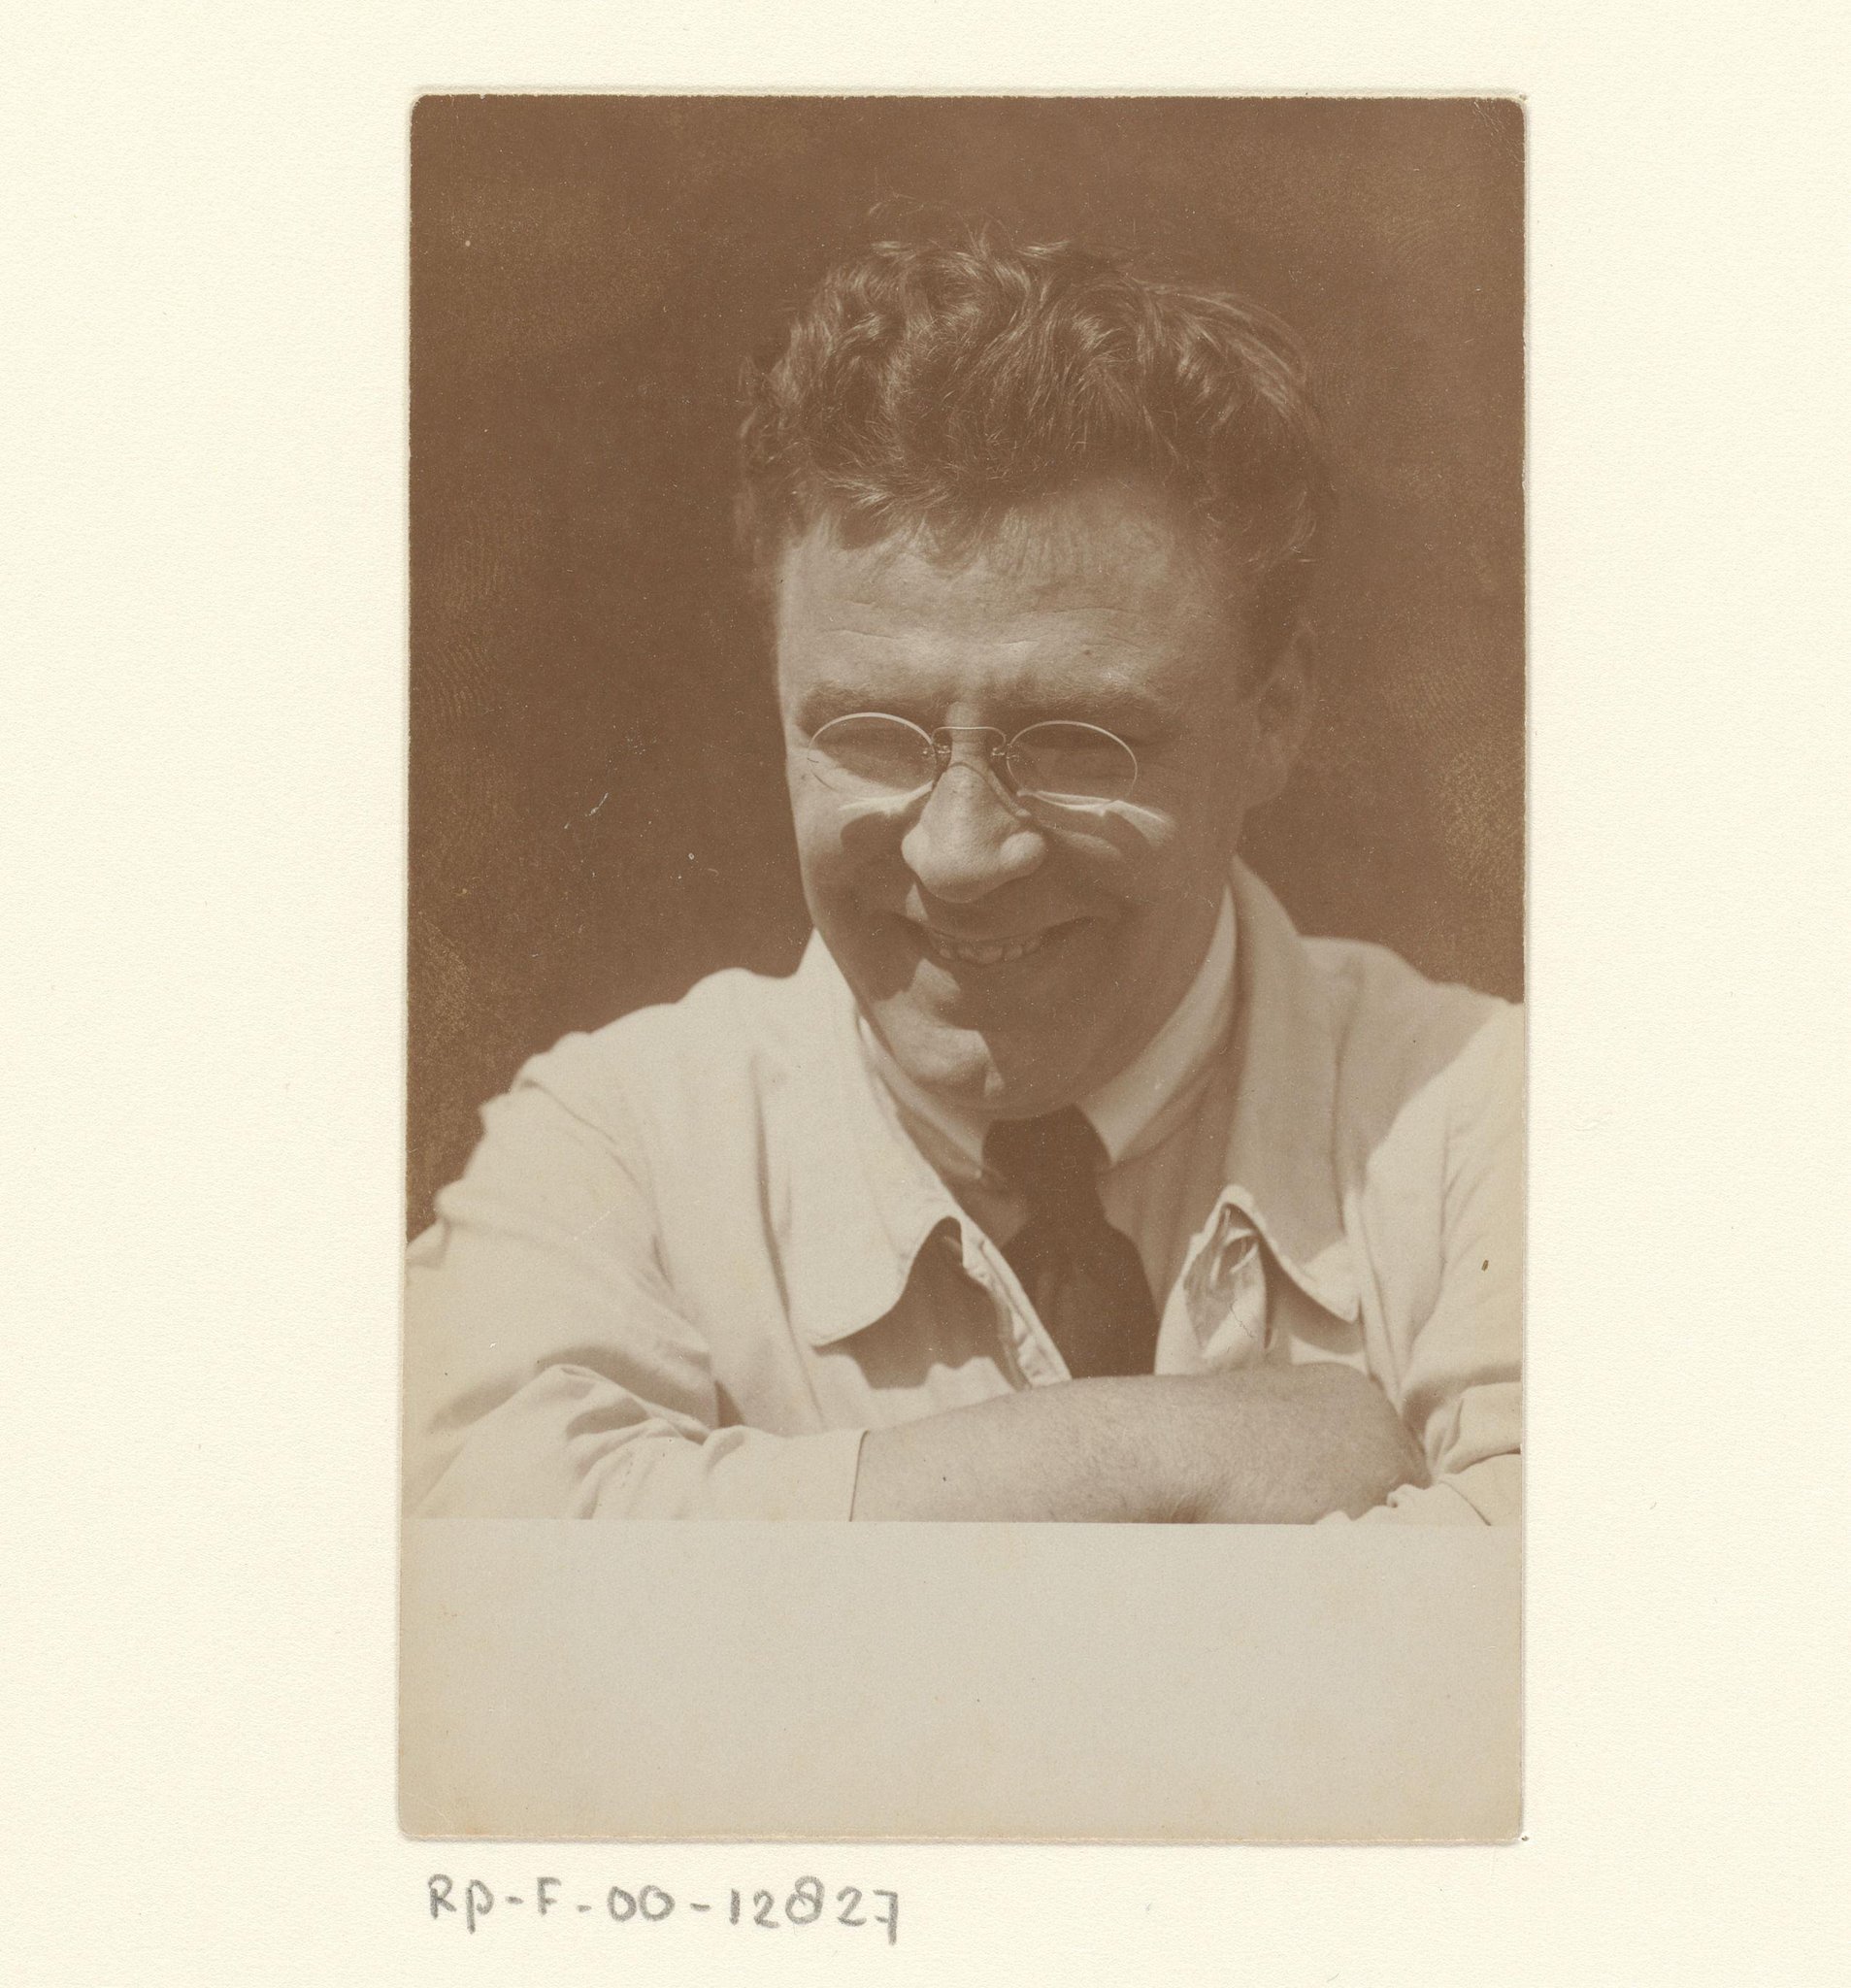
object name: photograph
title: Portret van Toon Depuis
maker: Anonymous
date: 1910-1930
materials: paper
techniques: gelatin silver print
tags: antwerp, sculptor, portrait, self-portrait of artist